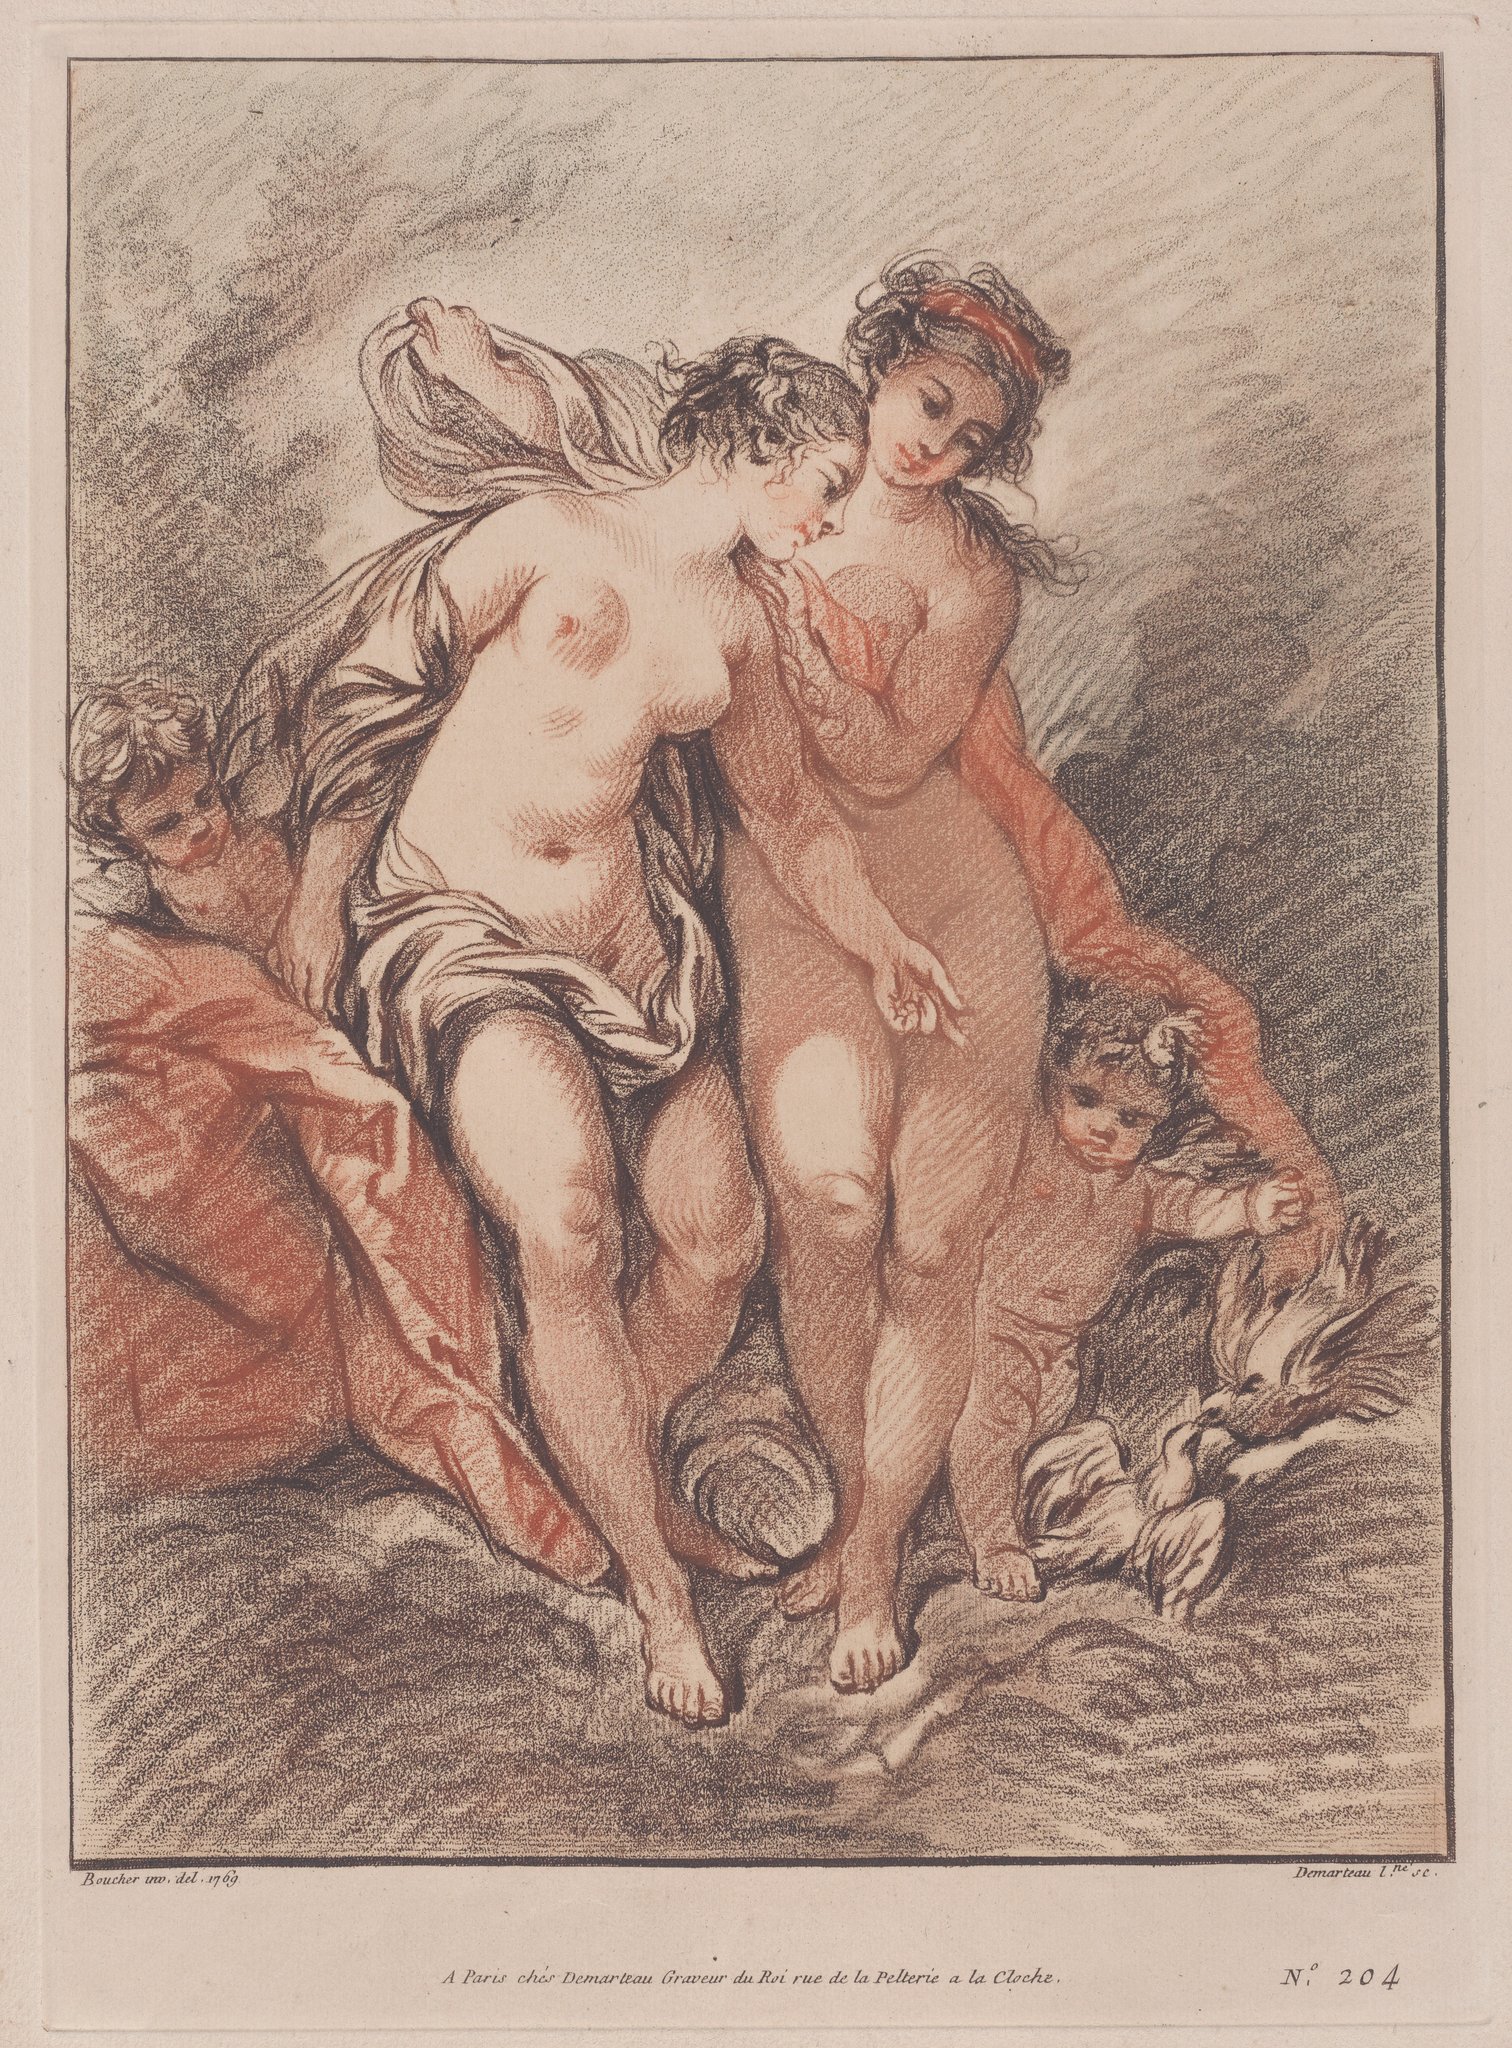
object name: print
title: Reproduction of Deux Nymphes et deux Amours regardant des colombes (Two Nymphs and Loves watching two doves)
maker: gilles demarteau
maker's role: artist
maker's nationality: french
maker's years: 1722-1776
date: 1769-1900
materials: ink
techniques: printmaking, engraving